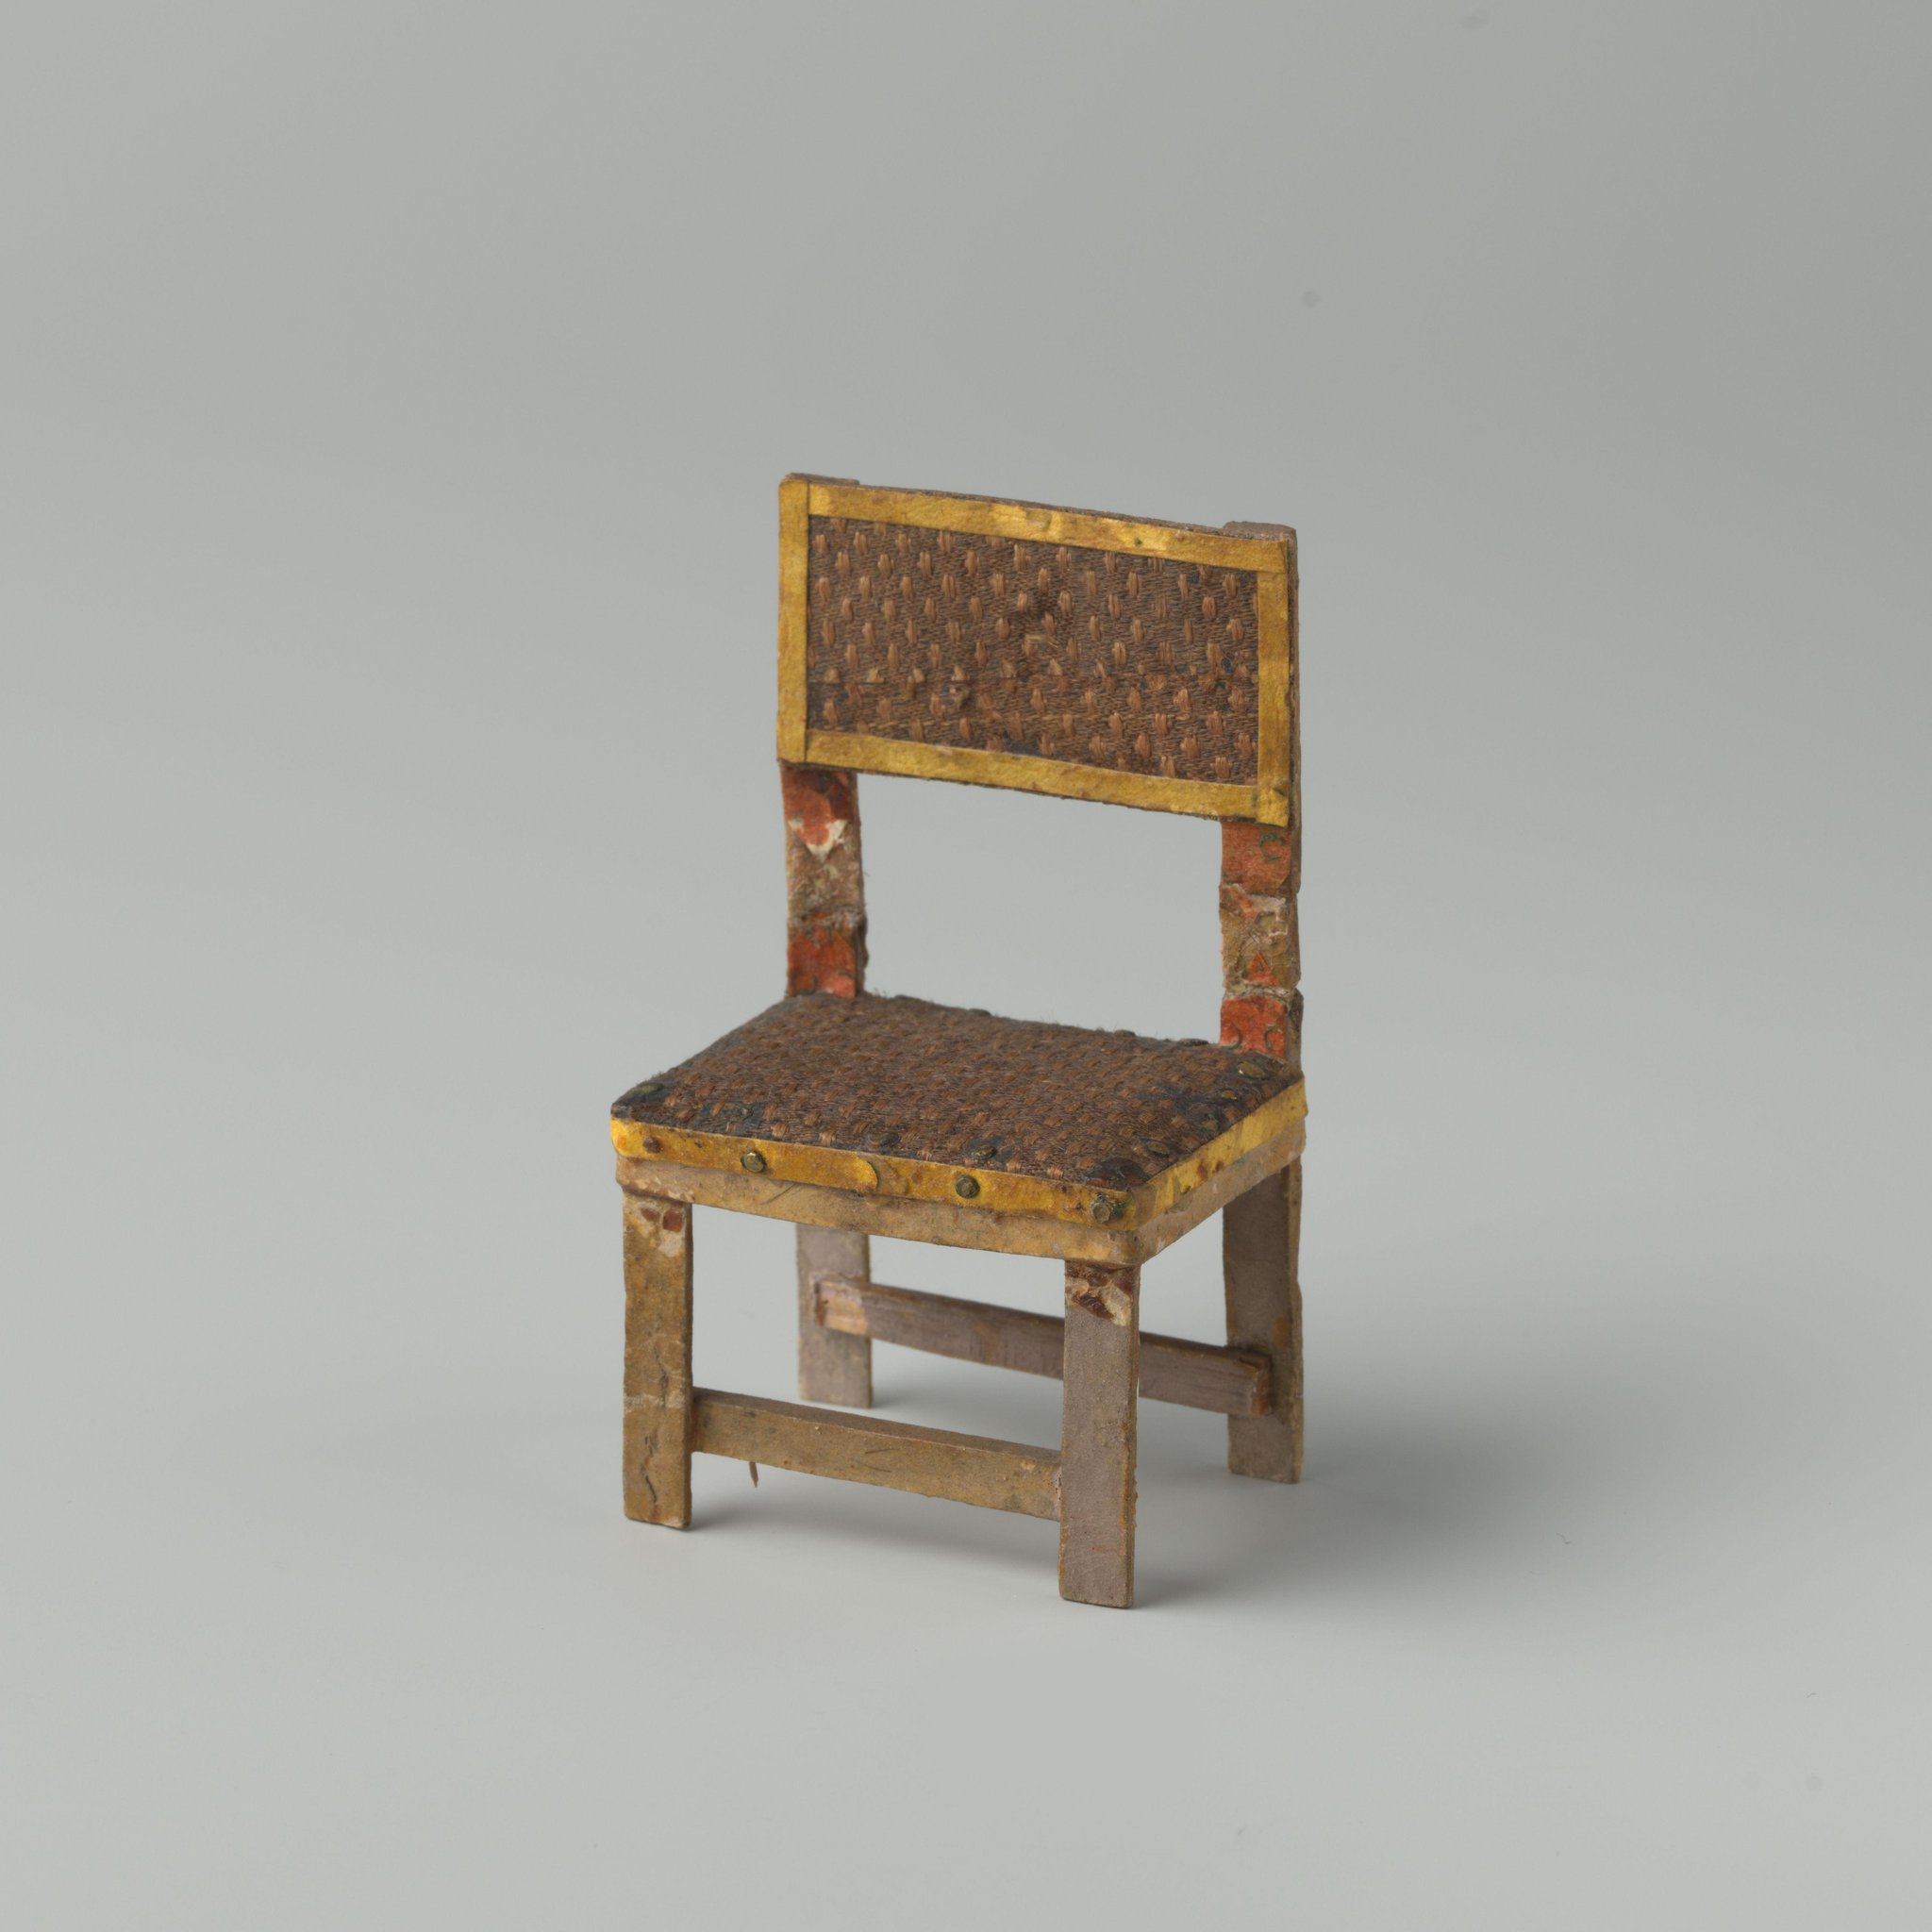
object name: chair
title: Stoel, vervaardigd van bordpapier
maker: Anonymous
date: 1676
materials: gouache, metal, board, silk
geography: amsterdam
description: Stoel, vervaardigd van bordpapier, met beklede zitting en rug. De rugstijlen, voorpoten, dwarsregels en onderkant zijn zachtpaars gekleurd. Zitting en rug zijn gestoffeerd en bekleed met zijde met bruine stippels op een zwarte ondergrond, afgezet met band van geelgelakt papier, waarop nagels van metaal. De papieren band loopt even door op de stijl tussen zitting en rug en eindigt in een punt van roodgekleurd papier.